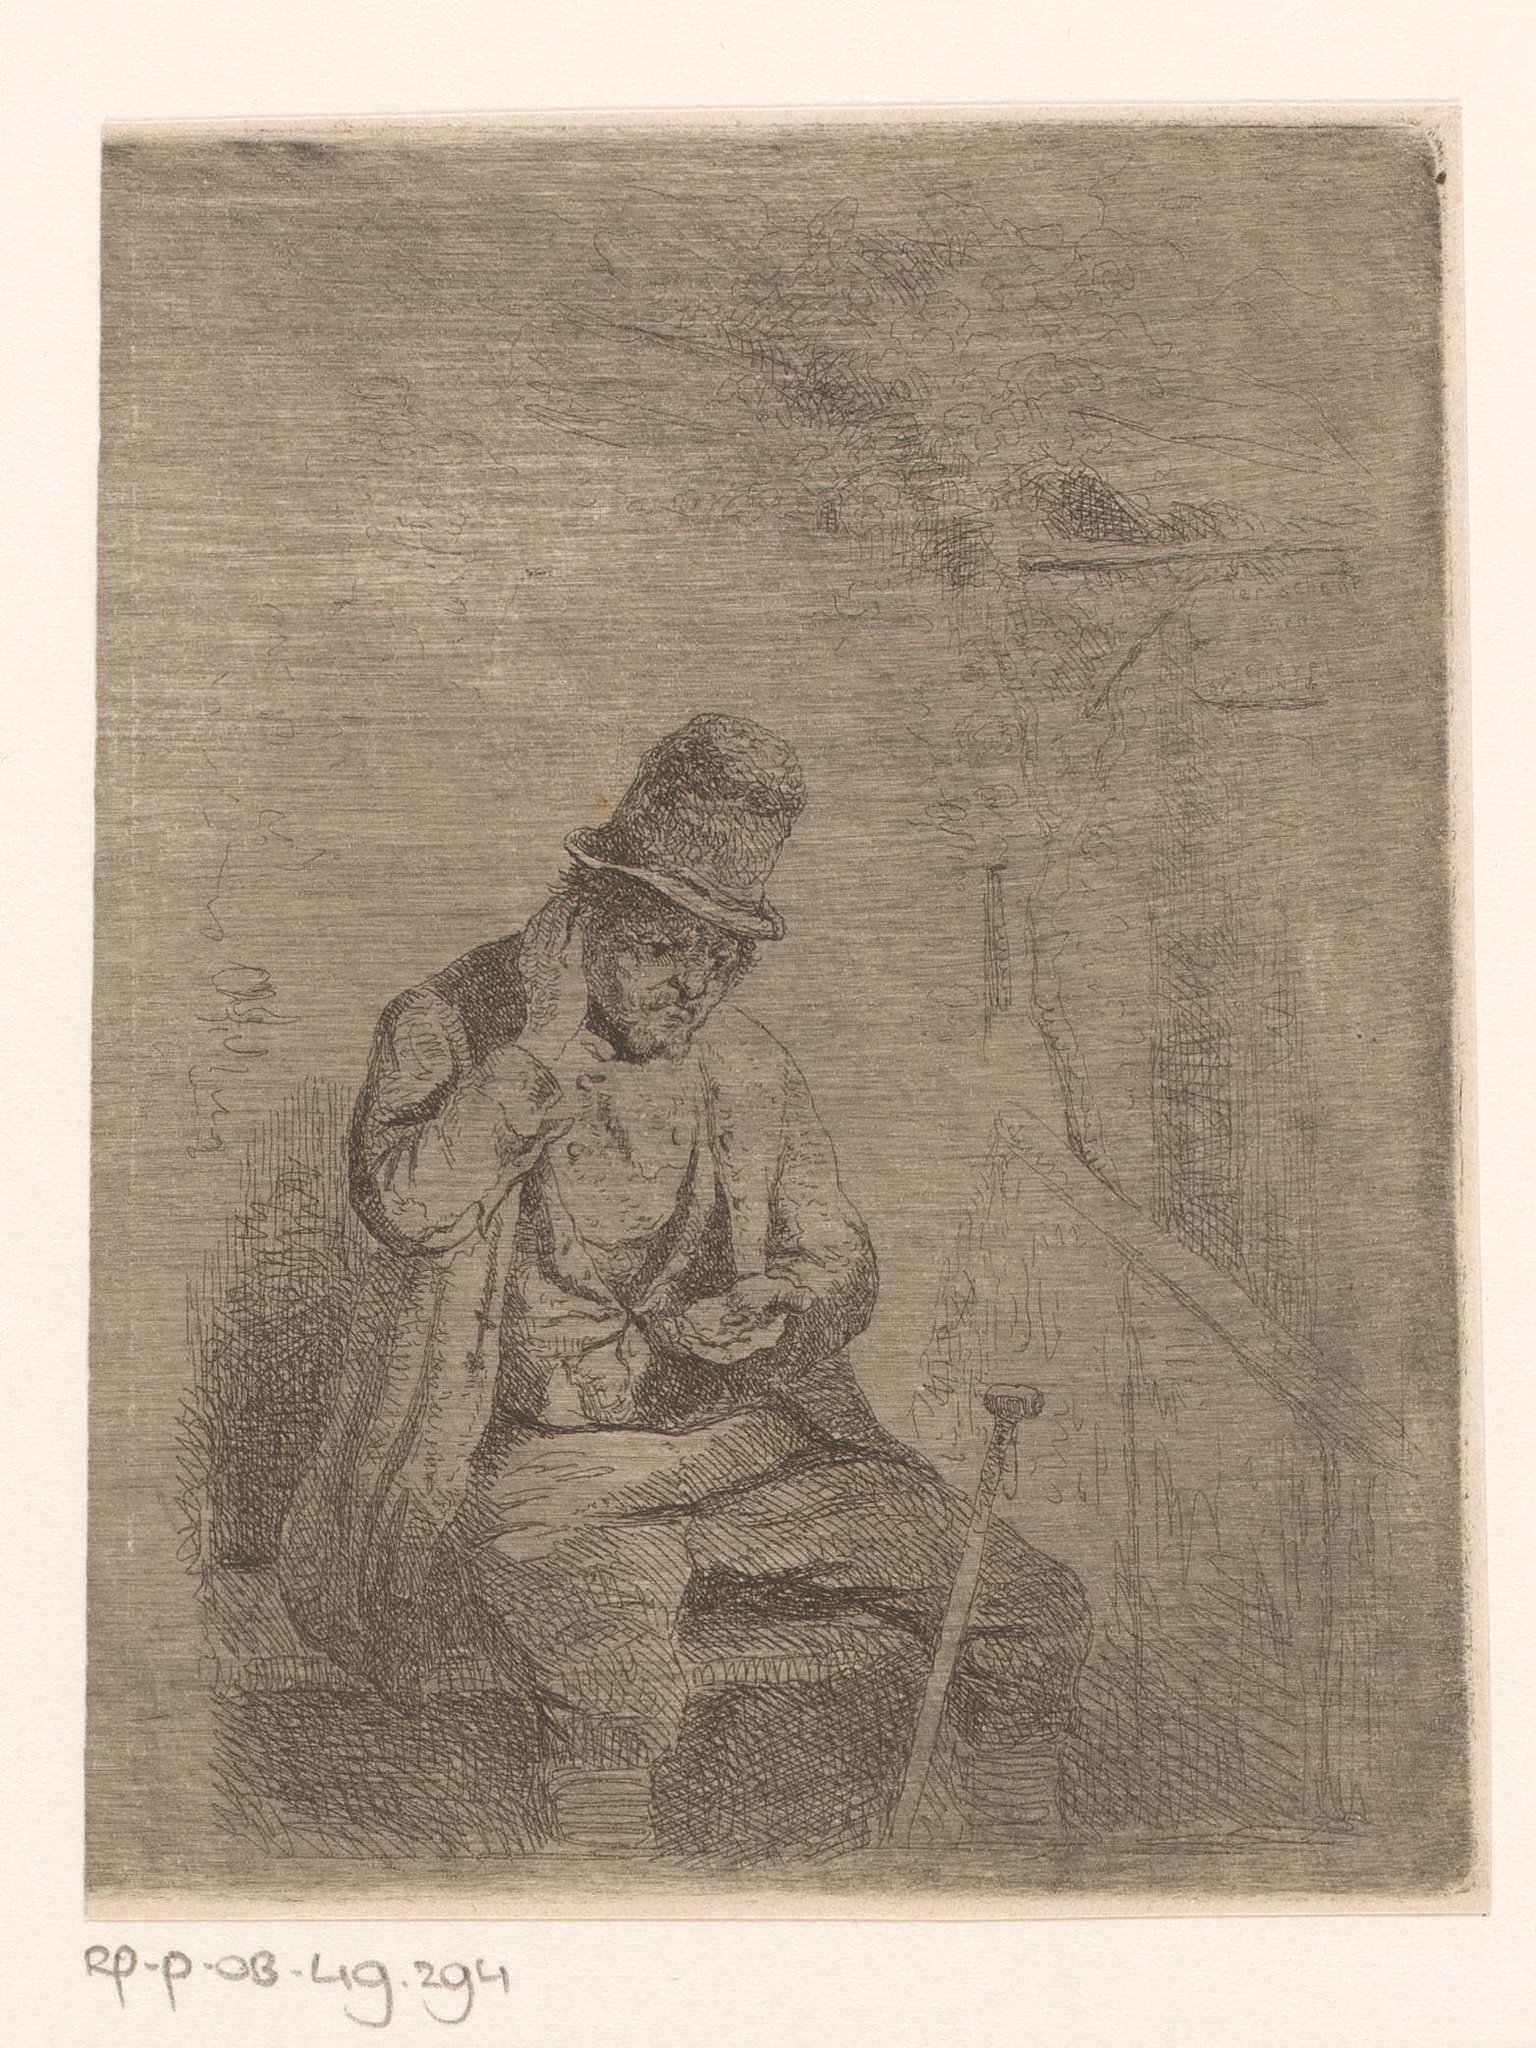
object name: print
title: Zittende man met munt in de hand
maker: willem linnig (i)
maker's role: print maker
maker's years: 1819-1885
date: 1846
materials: paper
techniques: etching, intaglio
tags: coin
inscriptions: collector's mark: Lugt 2228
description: Hoewel Hippert & Linnig deze prent toeschrijven aan Willem Linnig jr., is dat onwaarschijnlijk aangezien deze de prent dan op vierjarige leeftijd gemaakt zou moeten hebben.